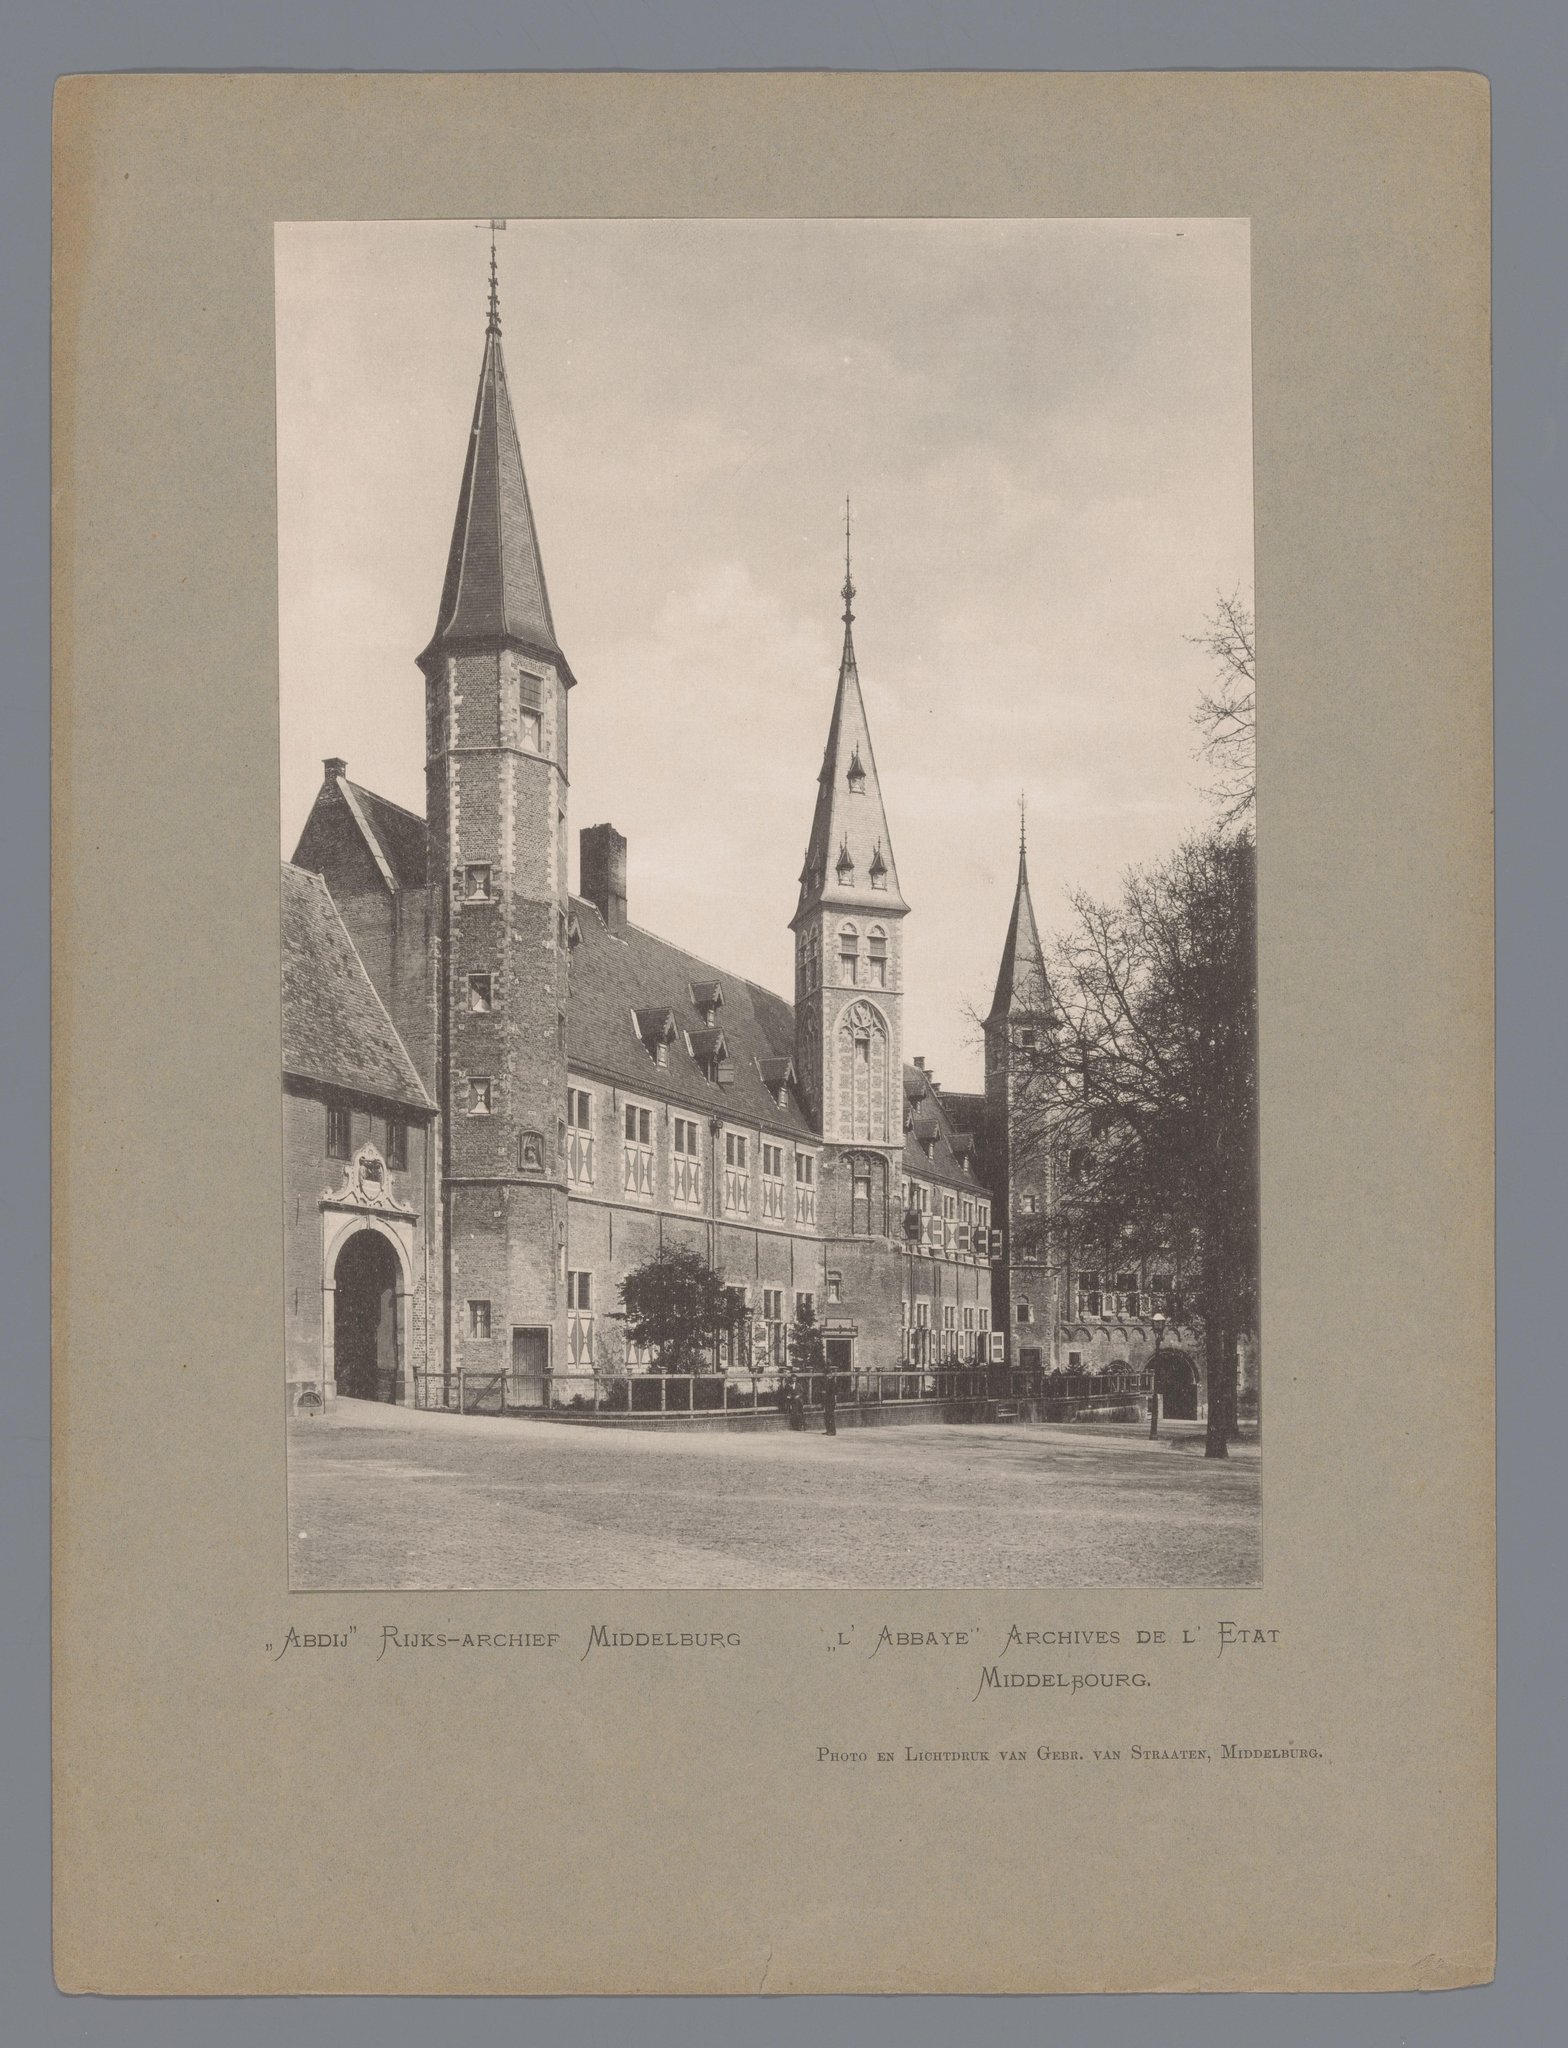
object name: photomechanical print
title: Abdij Rijks-archief Middelburg / L'Abbaye Archives de l'etat Middelbourg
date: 1890-1910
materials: paper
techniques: photograph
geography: middelburg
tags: archive, abbey, monastery, convent ~ roman catholic church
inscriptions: collector's mark: ‘Vosmaer’